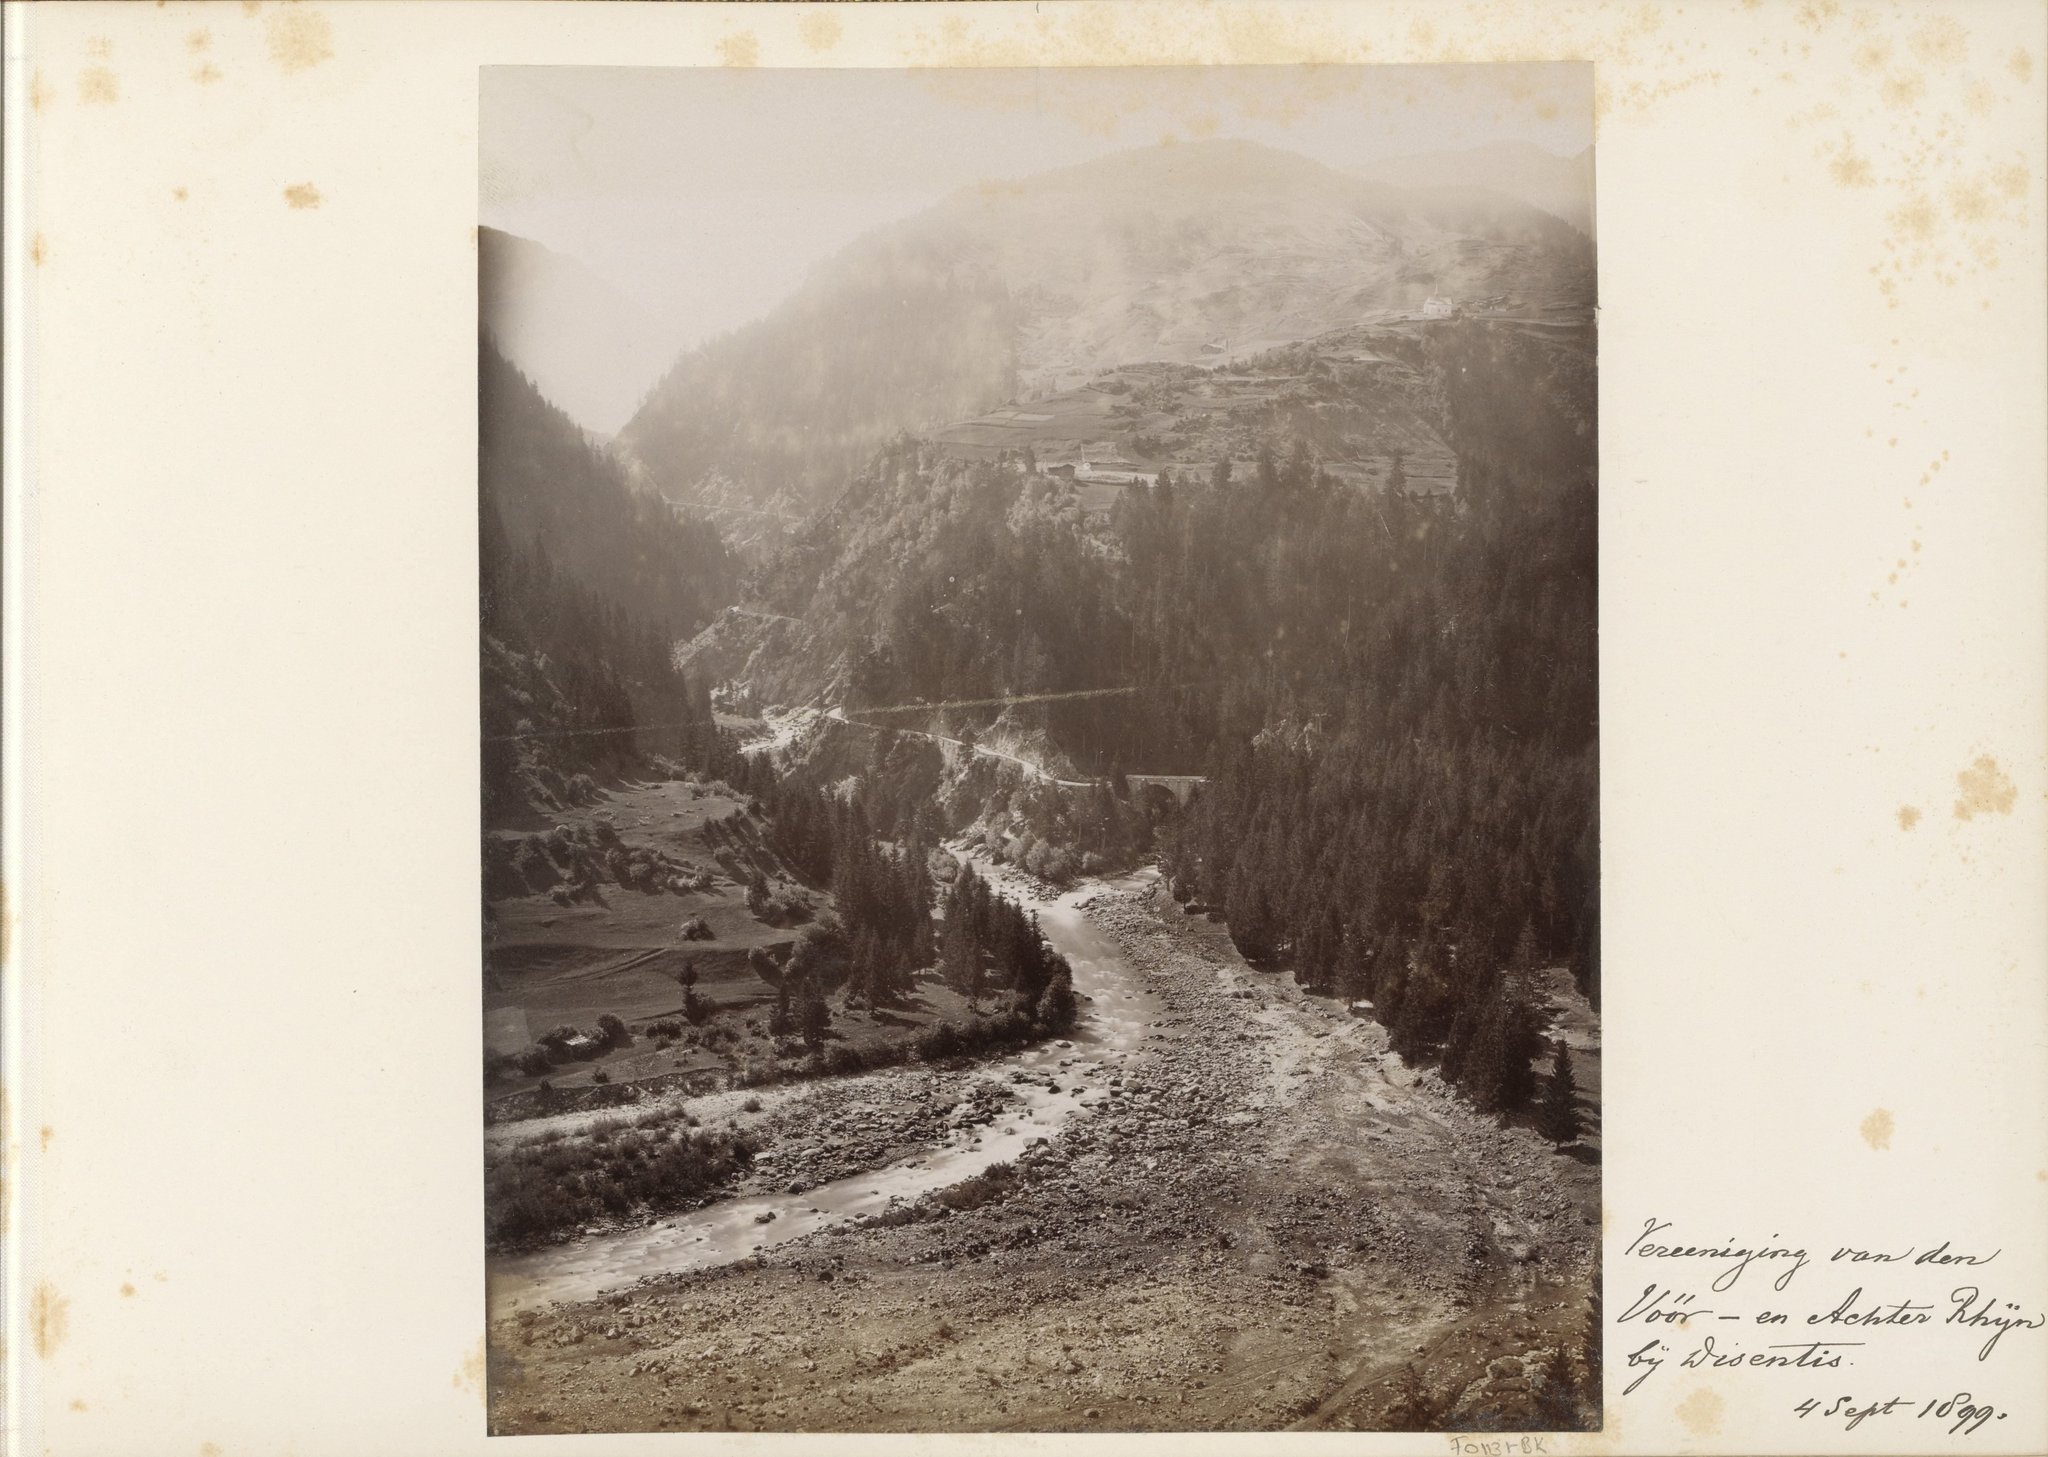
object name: album leaf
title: Samenloop van de Voor-Rijn en de Achter-Rijn bij Disentis-Mustér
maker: Anonymous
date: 1880-1899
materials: paper, photographic support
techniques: albumen print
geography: disentis-mustér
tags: river (+ landscape with figures, staffage)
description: Onderdeel van Reisalbum met bezienswaardigheden in Duitsland, Oostenrijk, Zwitserland, Luxemburg en België.